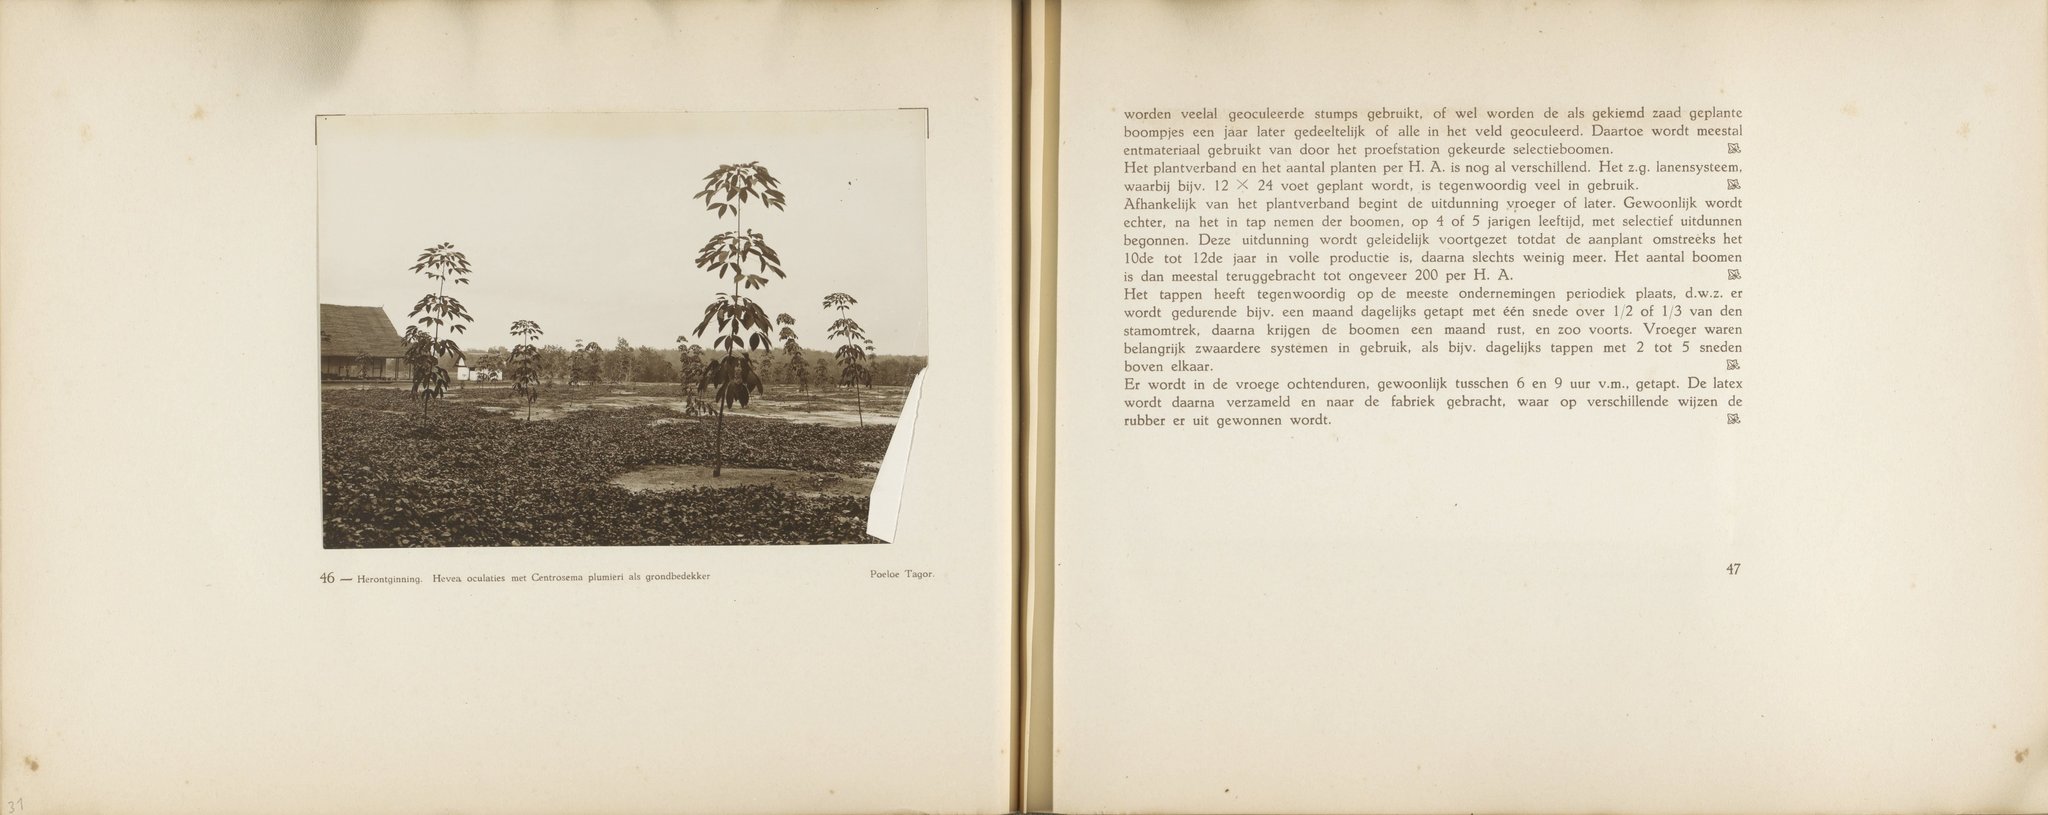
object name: album leaf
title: Pagina 46 en 47 van fotoboek van de Algemeene Vereeniging van Rubberplanters ter Oostkust van Sumatra (A.V.R.O.S.)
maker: j.w. meyster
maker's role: fotograaf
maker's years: 1887-1945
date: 1924-1925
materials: paper, photographic support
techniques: printing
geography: sumatra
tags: plantation, (non-fruit) products of plants or trees: rubber, sumatra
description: Twee boekpagina's met links een foto van geënte heveaplanten te Poeloe Tagor en rechts informatie over het de rubbercultuur. Onderdeel van een fotoboek van de Algemeene Vereeniging van Rubberplanters ter Oostkust van Sumatra (A.V.R.O.S.).